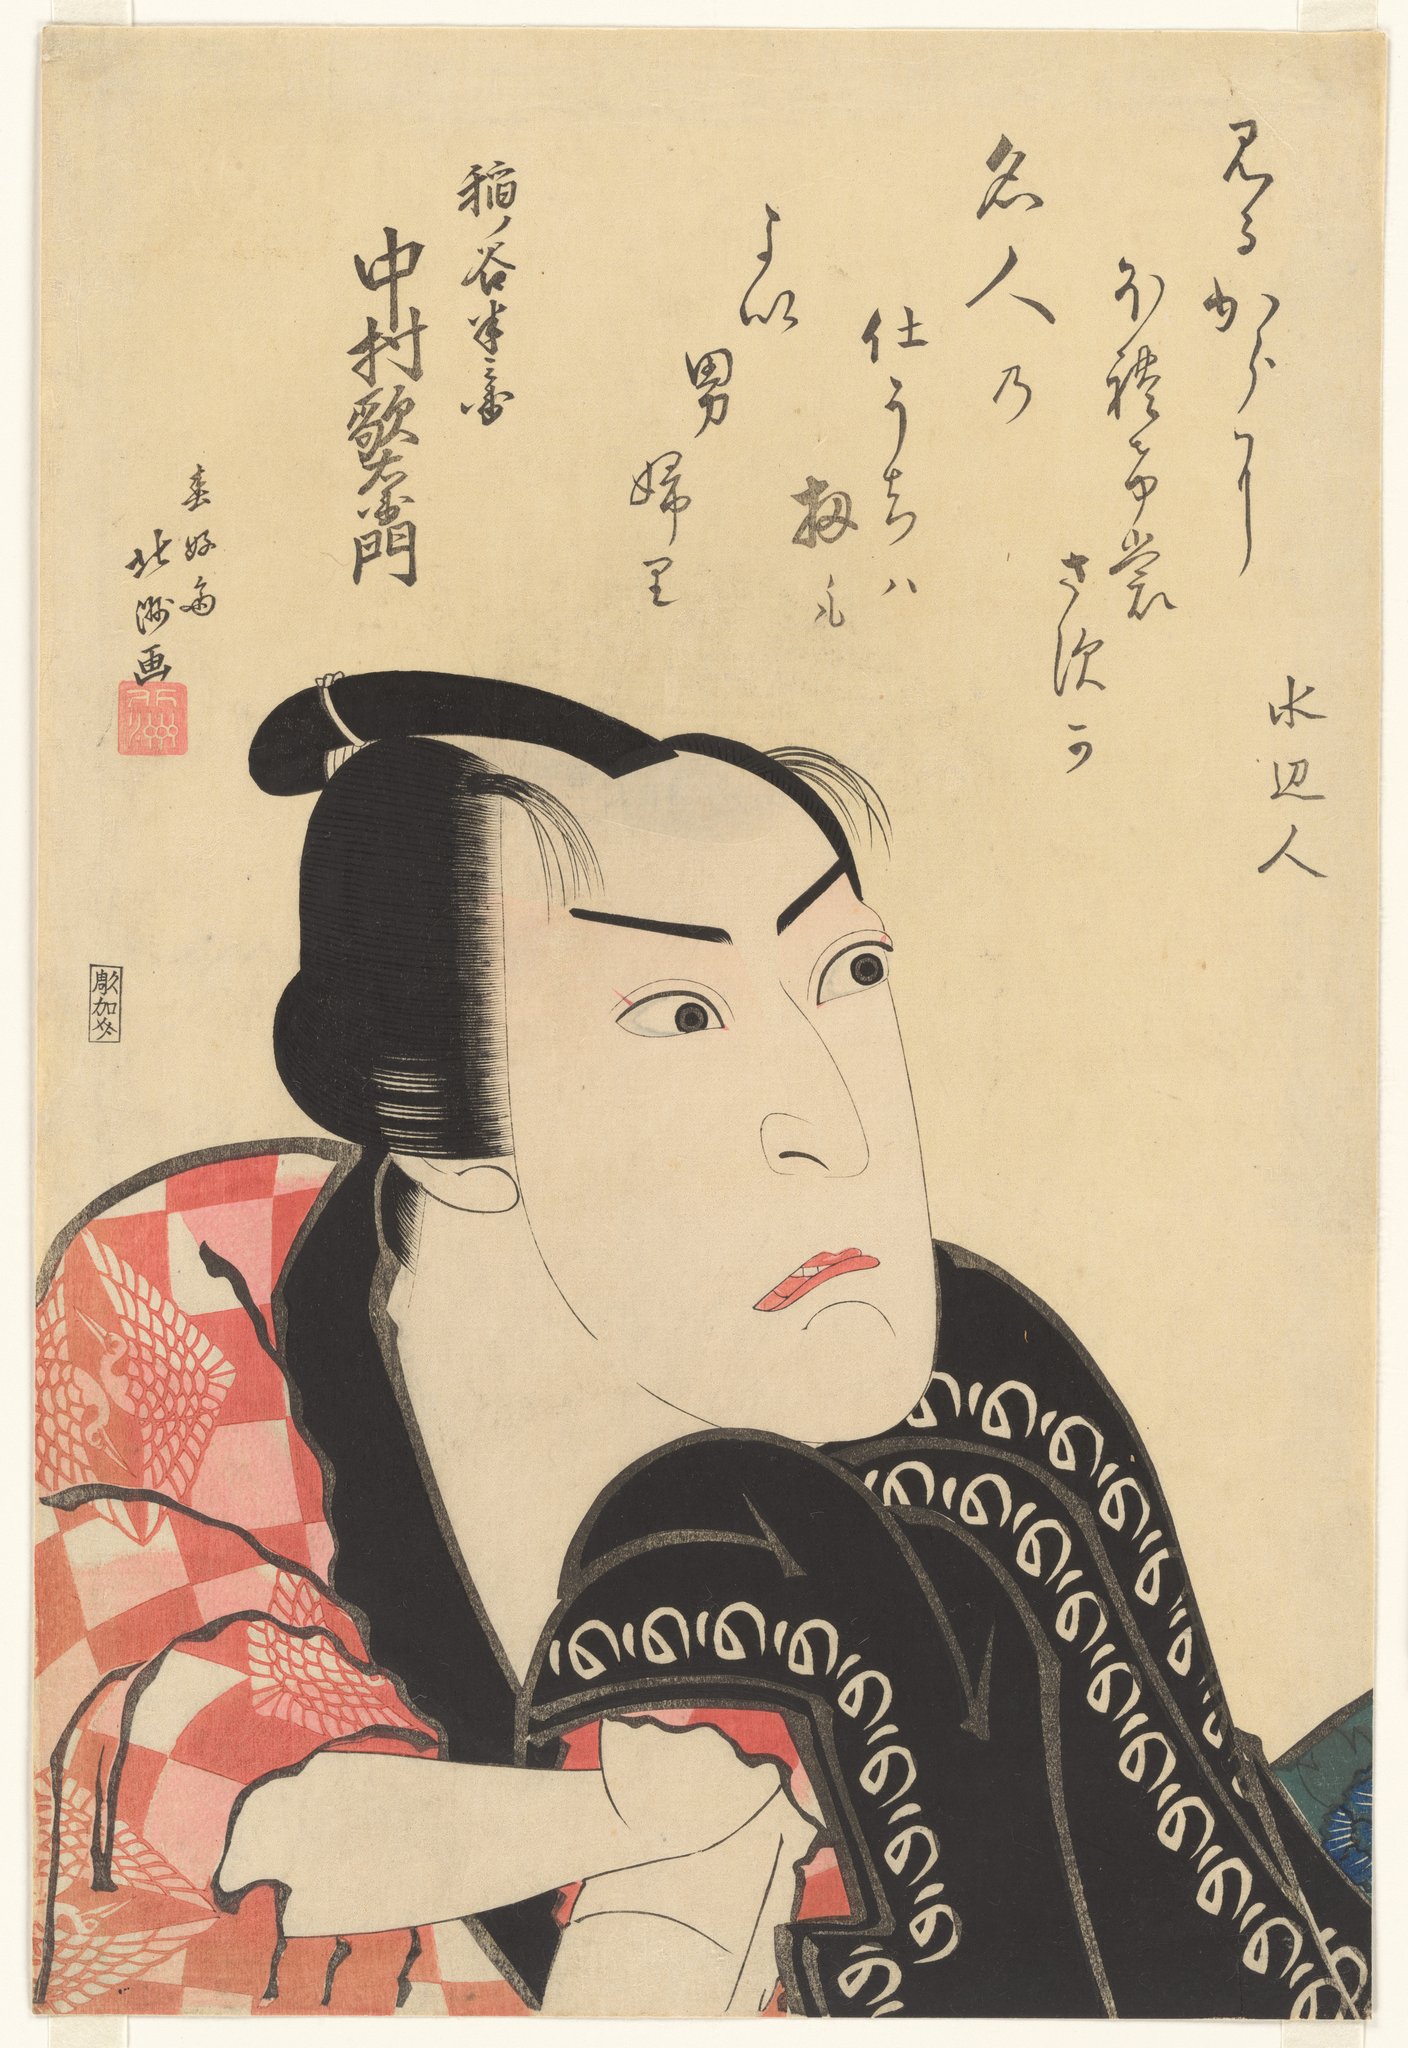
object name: woodblock print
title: The Actor Nakamura Utaemon III as Inanoya Hanbē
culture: japanese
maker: shunkōsai hokushū 春好斎北洲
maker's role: artist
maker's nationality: japanese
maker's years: 1808-1832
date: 1820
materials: ink, paper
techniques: nishiki e, woodblock print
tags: men,actors